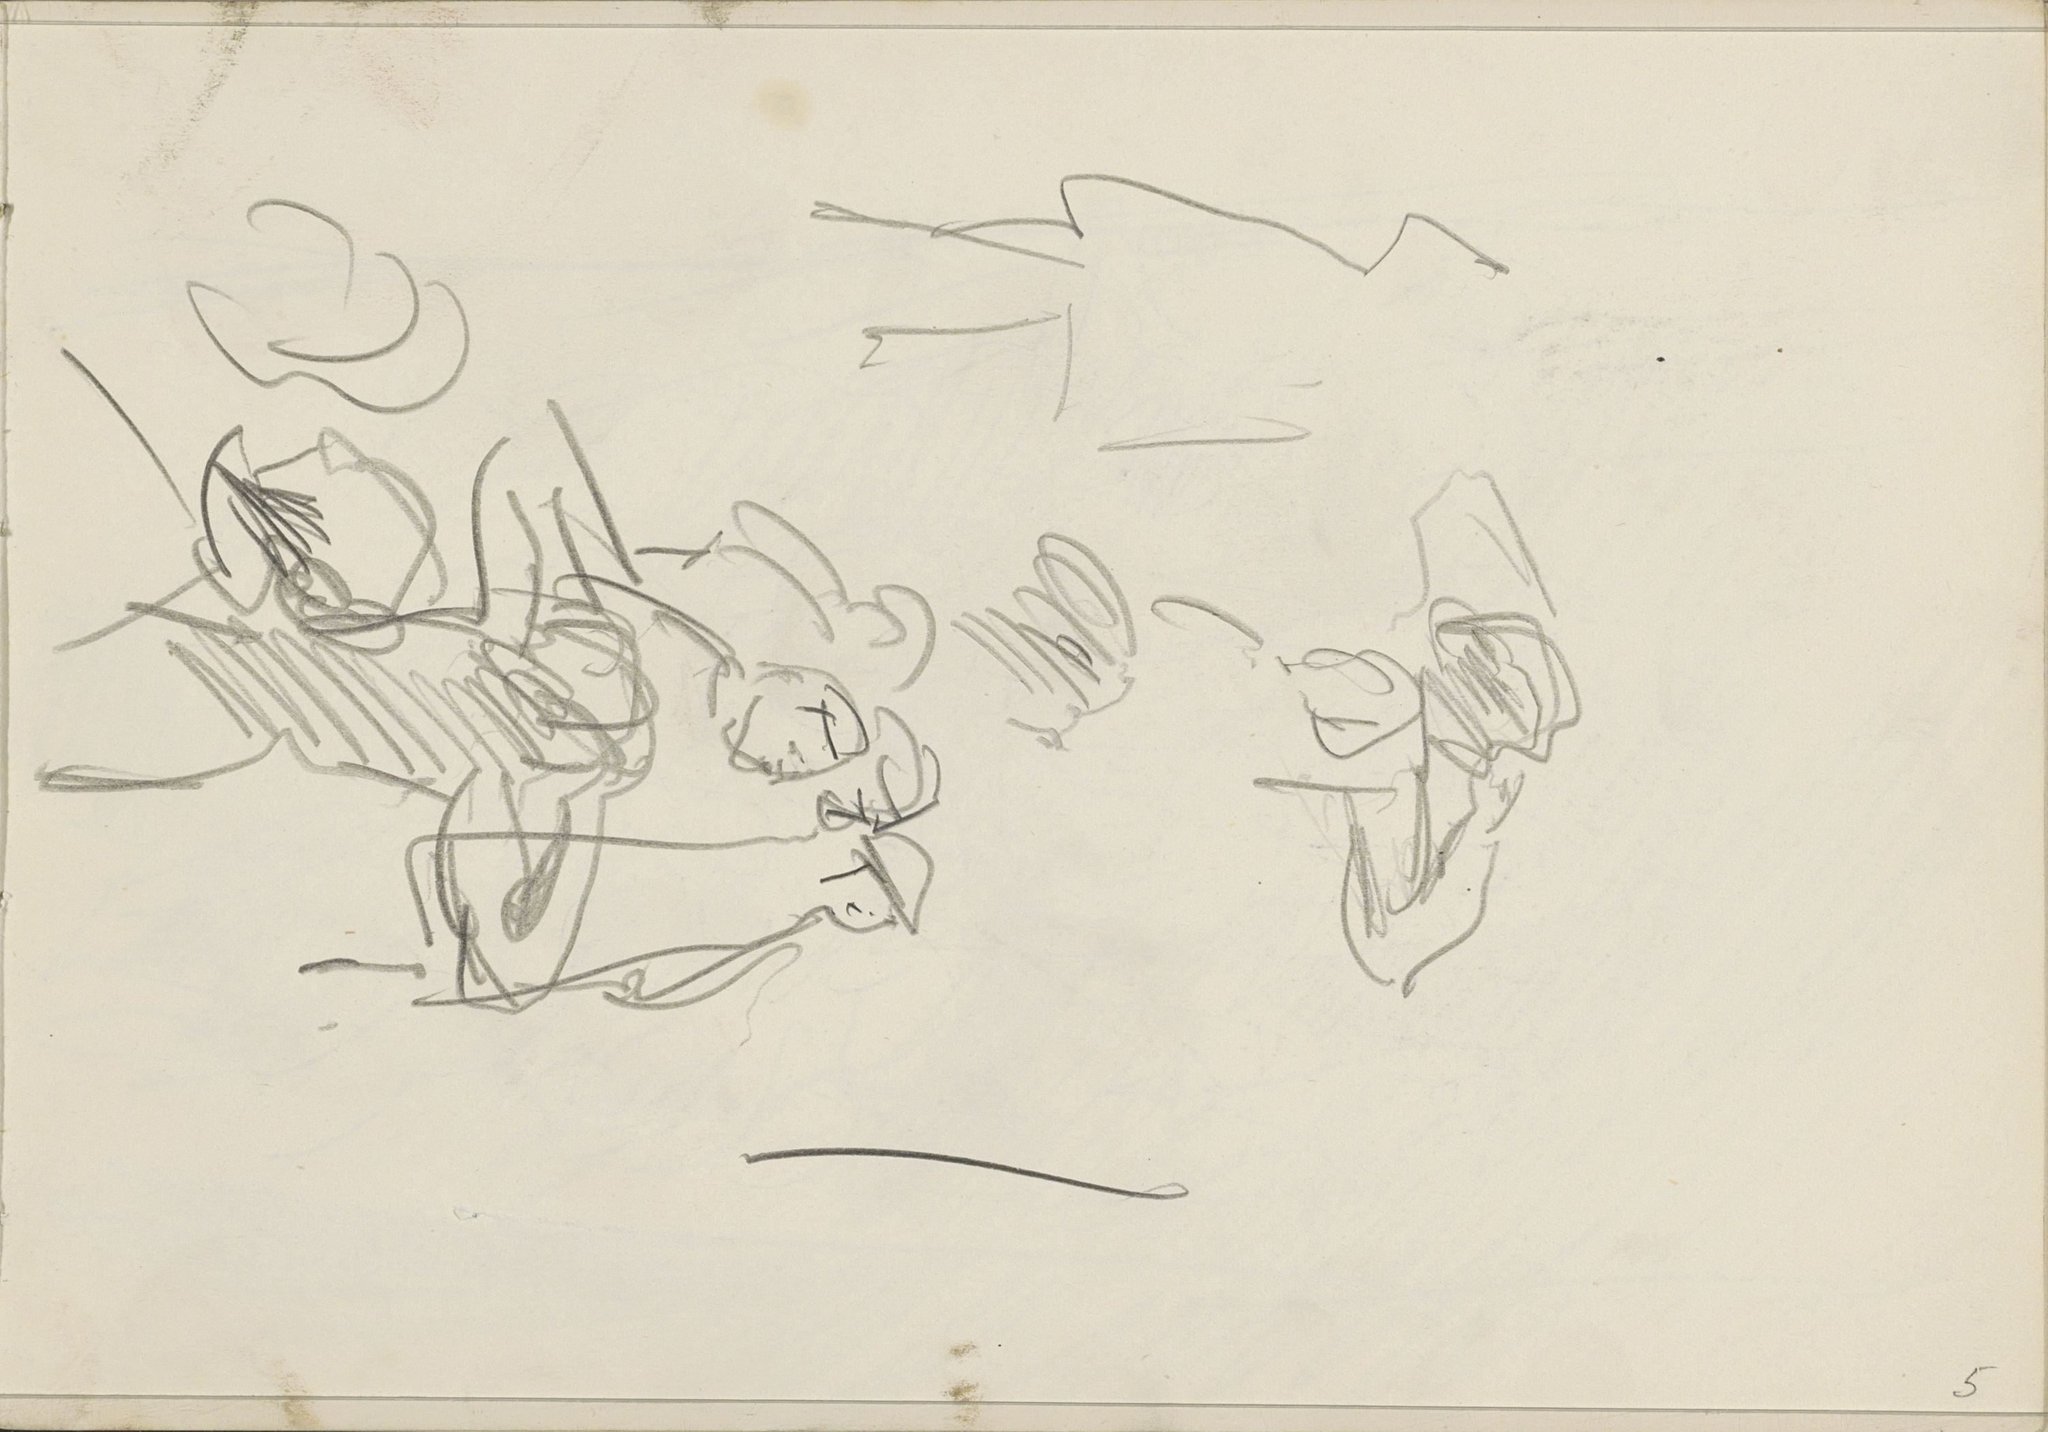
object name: sketchbook leaf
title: Figuurstudies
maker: isaac israels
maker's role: draughtsman, painter, print maker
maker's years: 1865-1934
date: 1915-1934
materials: paper, pencil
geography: the hague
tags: adult woman (+ standing), adult man (+ standing)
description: Blad 5 recto uit schetsboek XXV met 23 bladen.